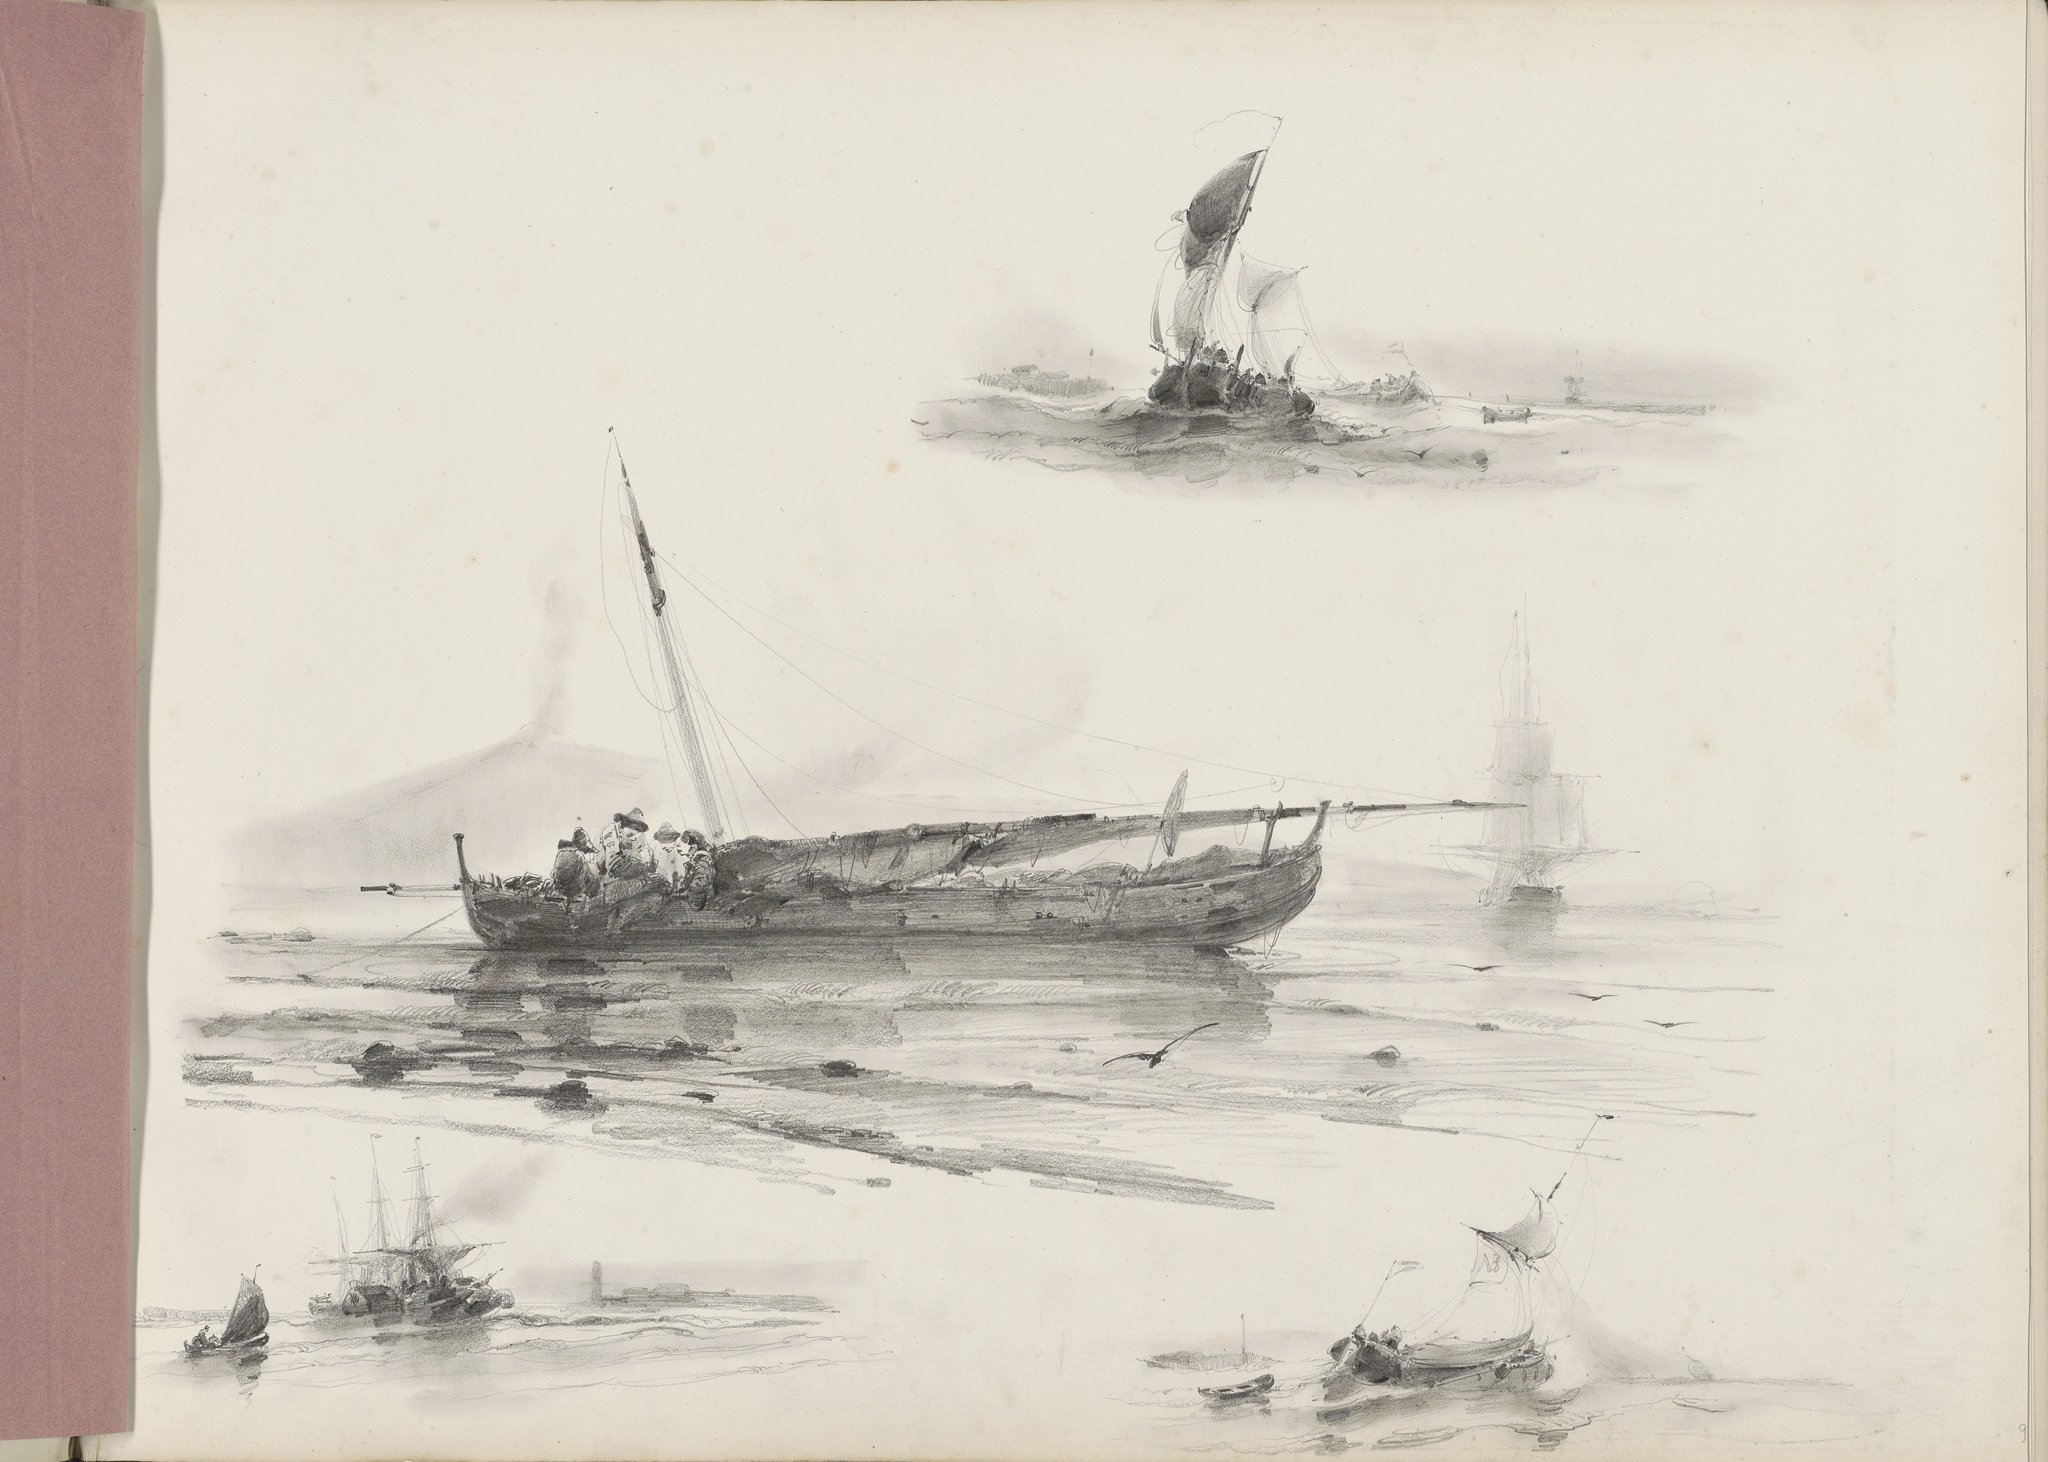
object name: sketchbook leaf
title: Figuren op een afgemeerd zeilschip voor een kust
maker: albertus van beest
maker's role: draughtsman, print maker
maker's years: 1820-1860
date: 1830-1860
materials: paper, pencil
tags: sailing-ship, sailing-boat, rowing-boat, canoe, etc., coast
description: Tevens studies van zeilschepen op het water. Blad 9 recto uit een schetsboek met 10 bladen.